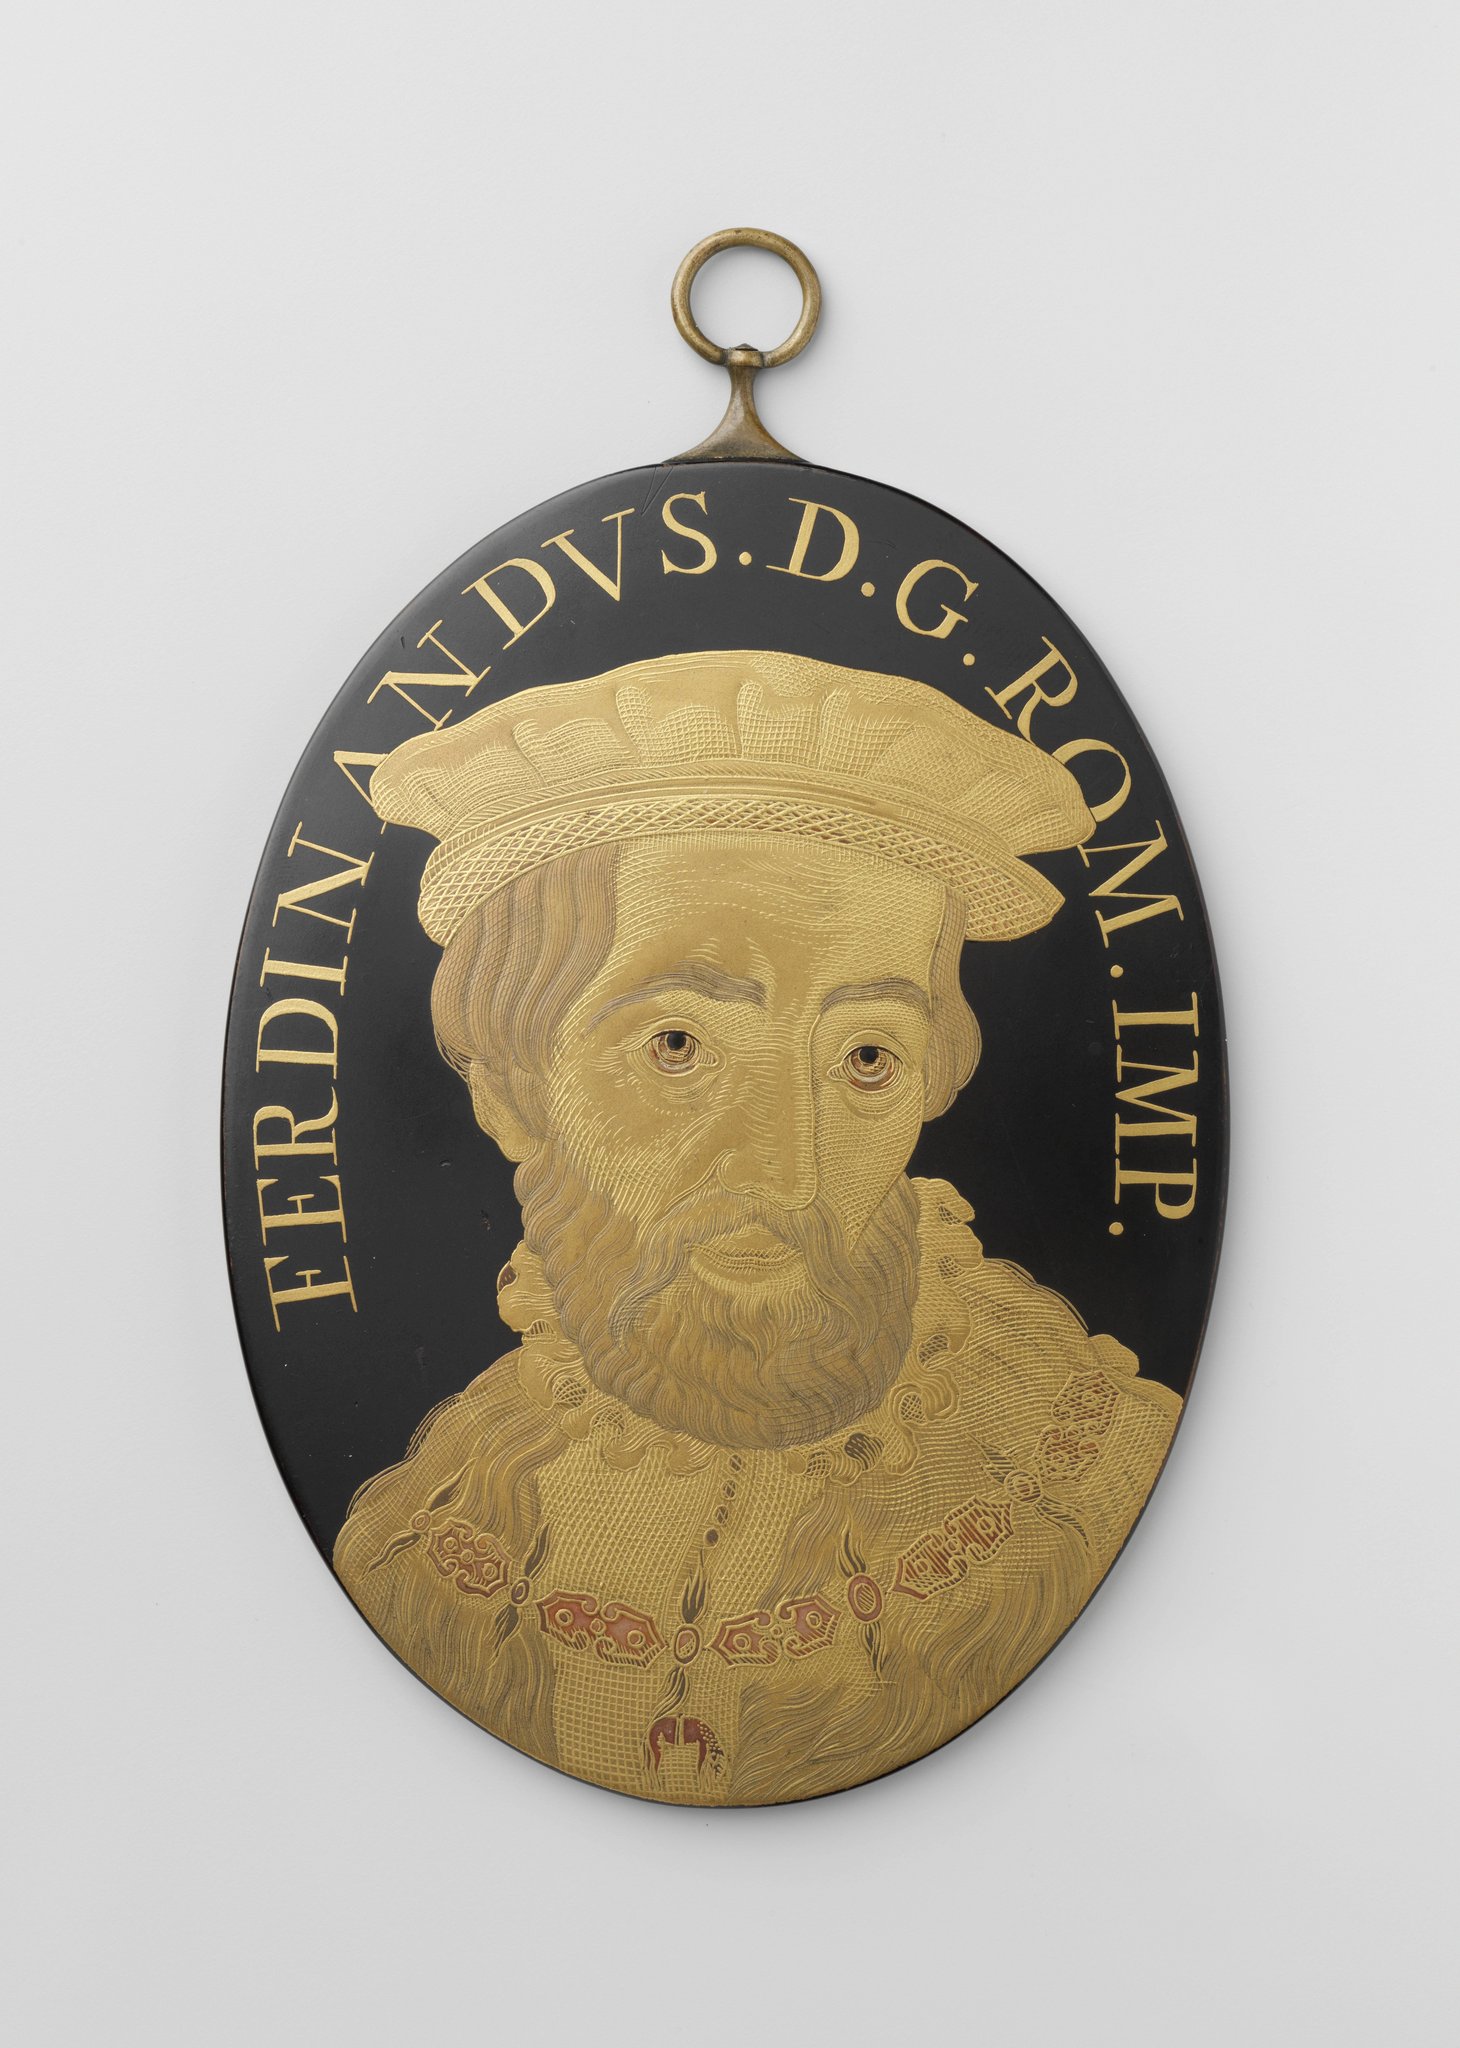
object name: plaque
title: Ferdinand I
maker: Anonymous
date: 1775-1800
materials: copper, lacquer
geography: japan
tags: vienna, ferdinand i van habsburg (duits keizer)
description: Portraits of European monarchs and scholars. Japan, last quarter 18th century. The VOC exported lacquer products commissioned specifically for the European market. Working from European prints, Japanese craftsmen made series of portraits for the VOC.